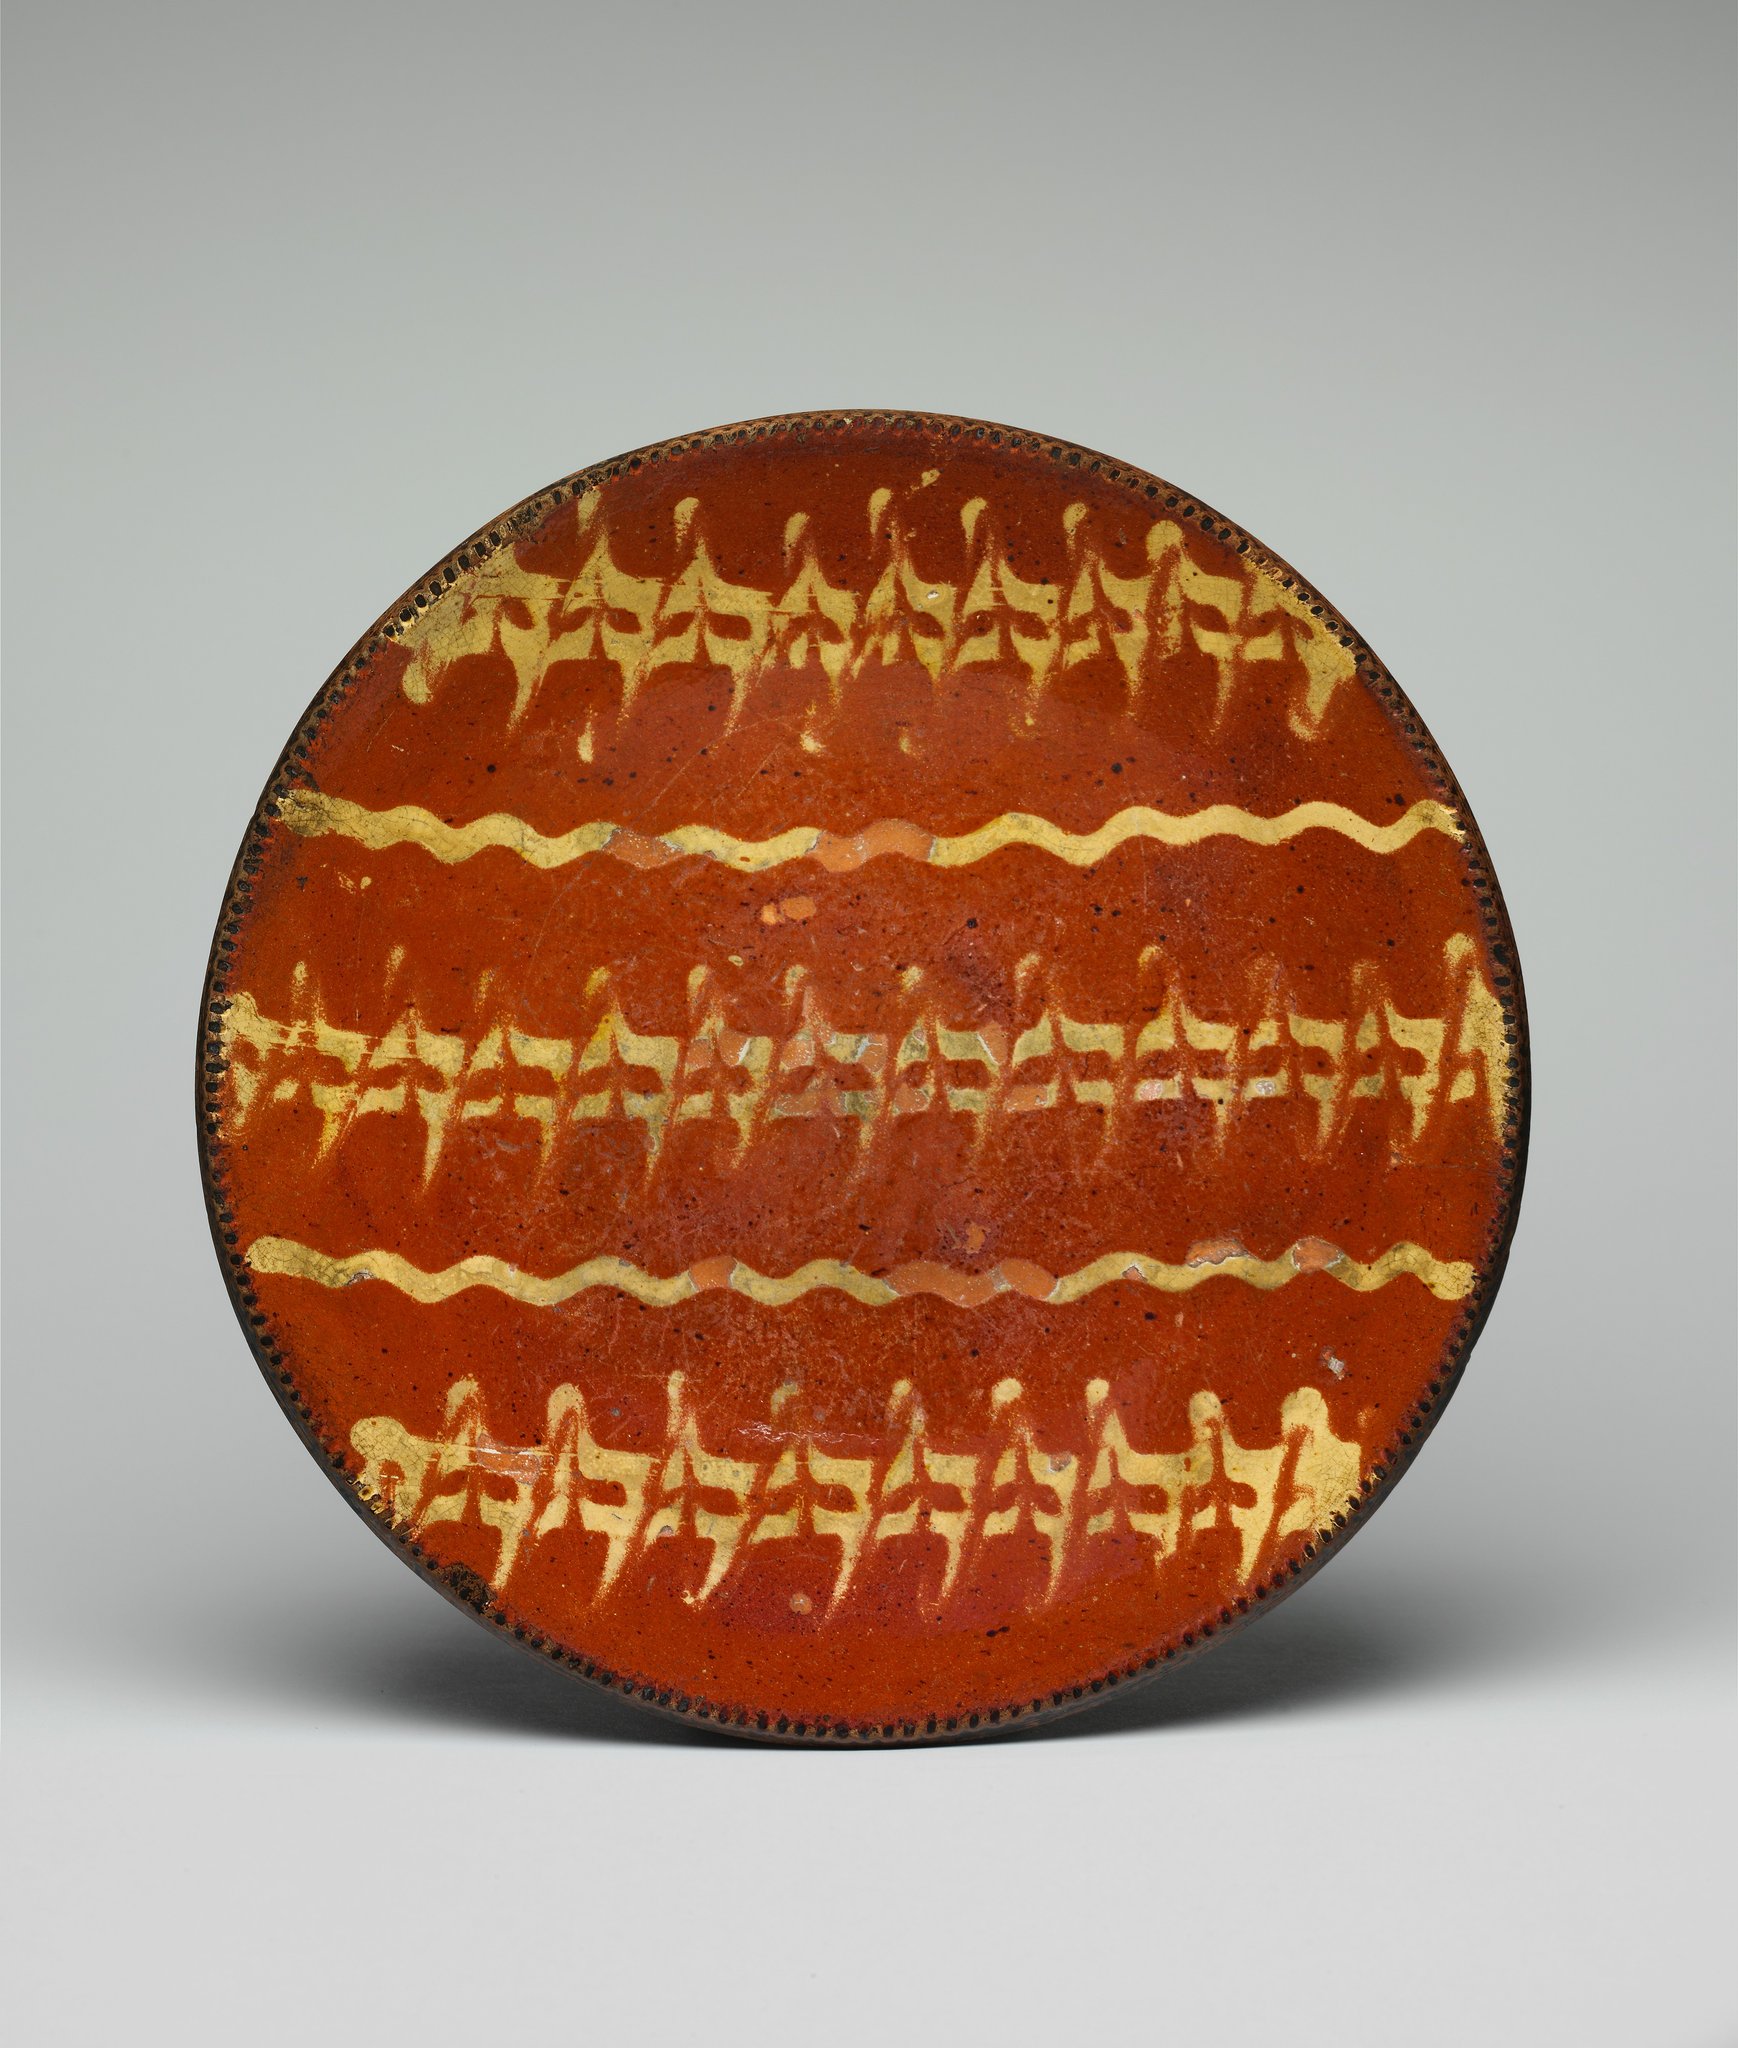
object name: plate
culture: american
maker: joseph mccully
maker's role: maker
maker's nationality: american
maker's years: 1757-1820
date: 1800-1850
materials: earthenware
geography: united states